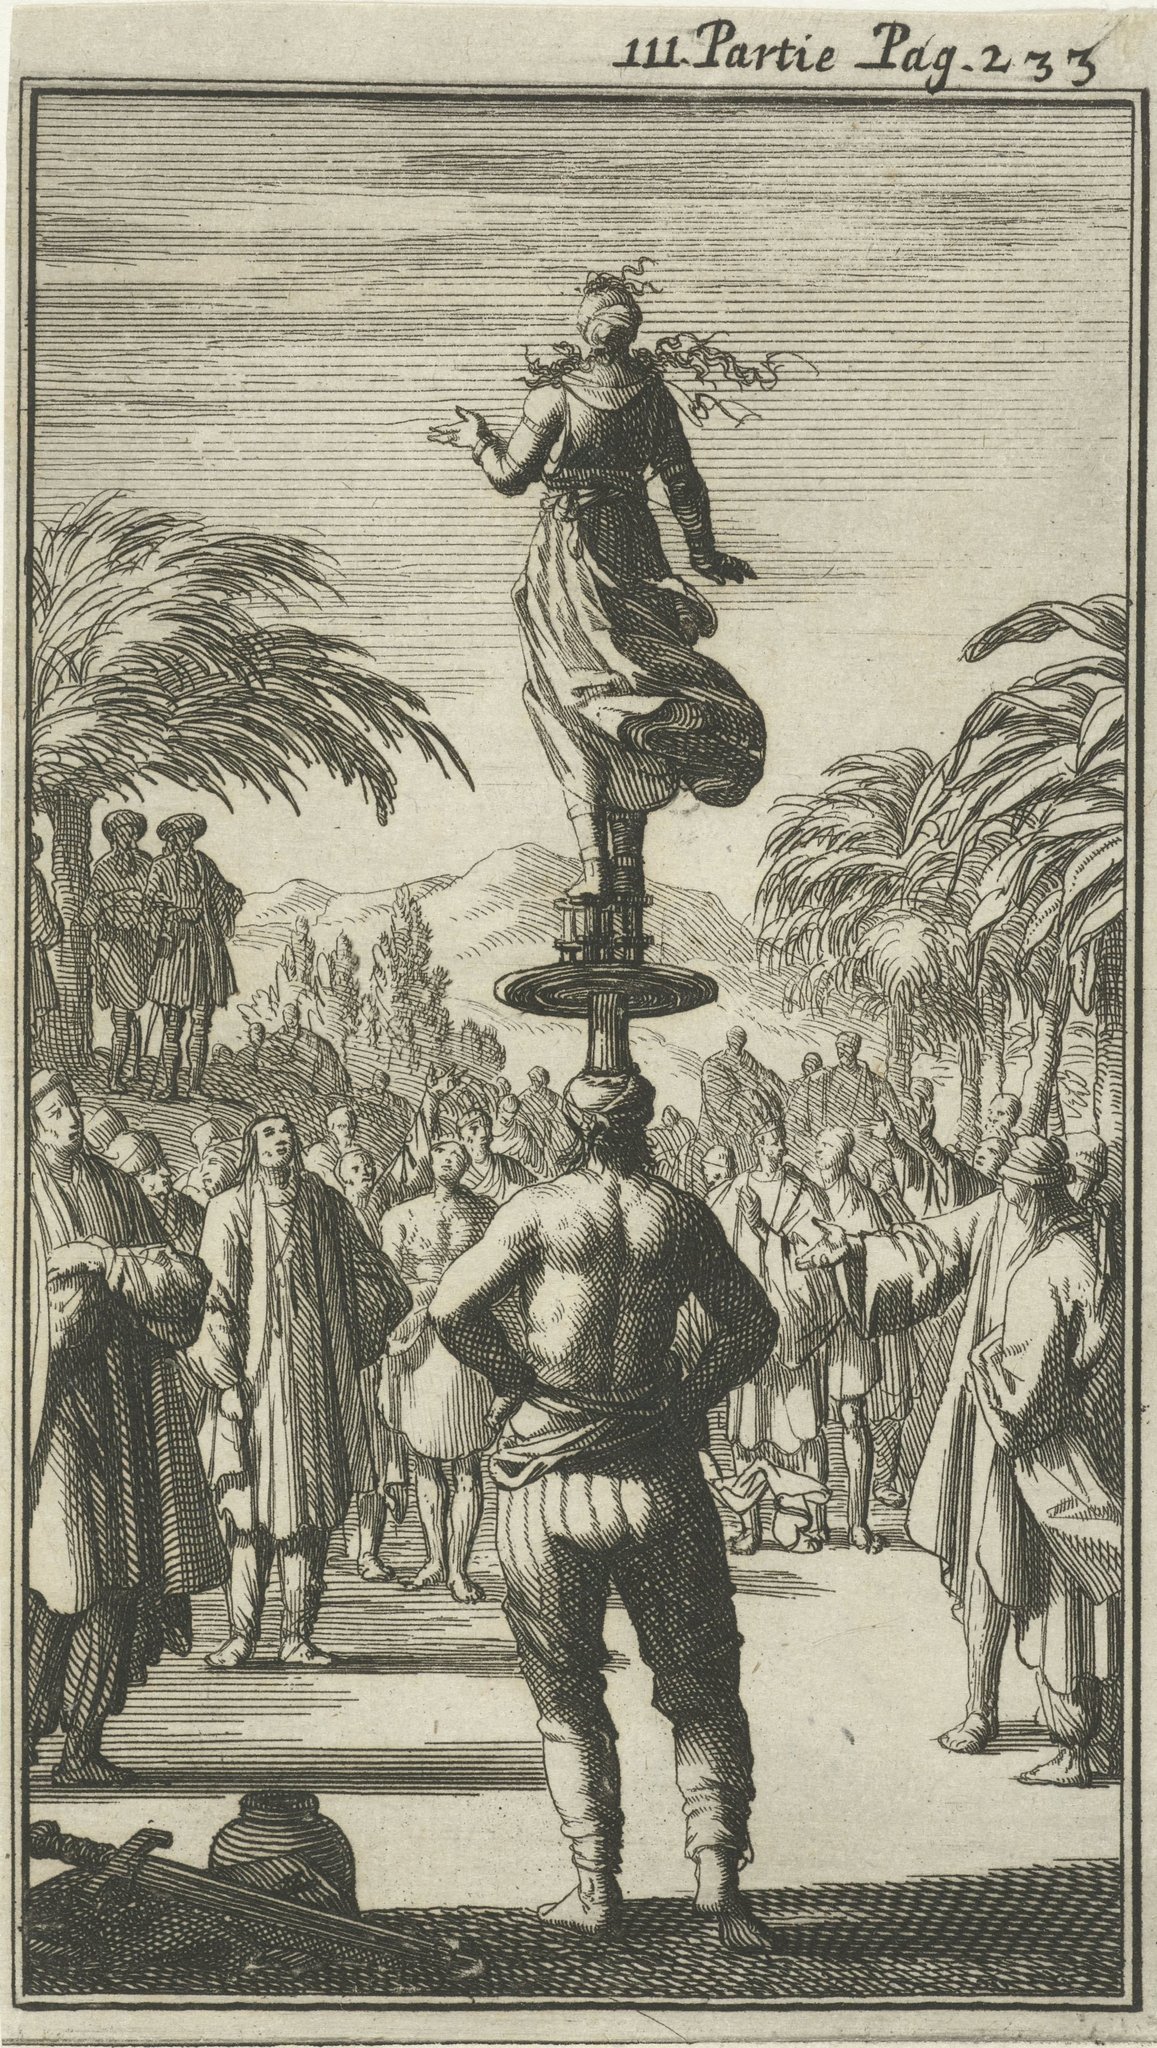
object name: book illustration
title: Indiase acrobaten te Patoda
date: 1689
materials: paper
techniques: etching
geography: amsterdam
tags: acrobat ~ circus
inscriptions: collector's mark: Lugt 2228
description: Illustratie uit: Thevenot, Jean de. Voyages Tant en Europe qu'en Asie et en Afrique, 4 delen. Parijs: Charles Angot, 1689, dl. IV.